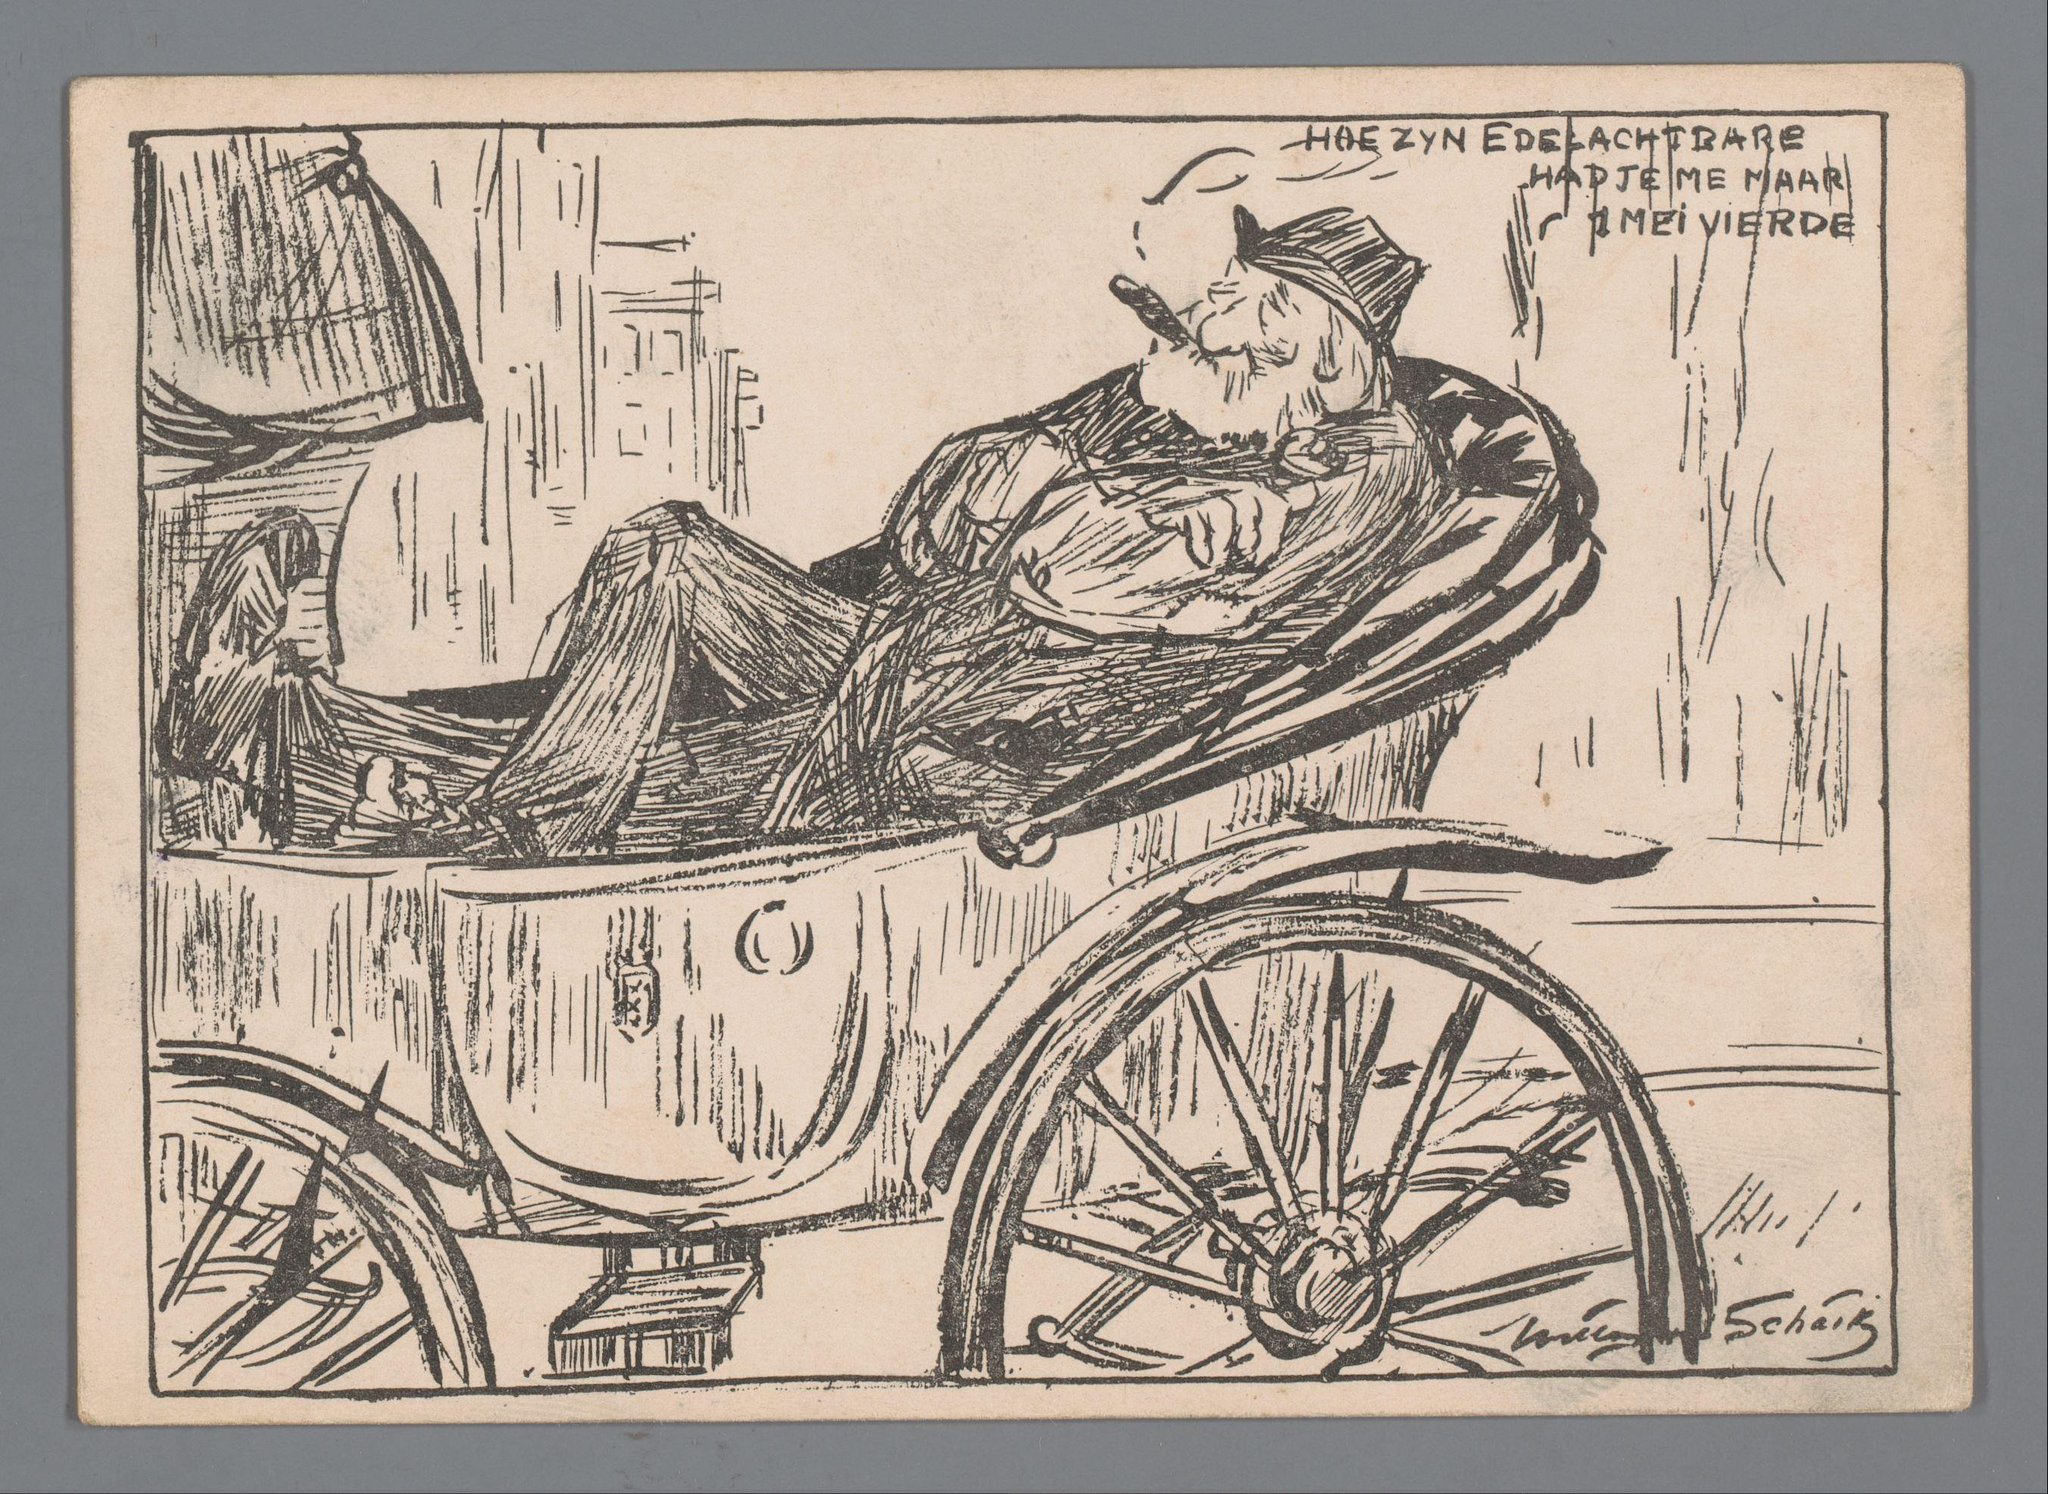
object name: postcard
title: Tweede Kamer droom van "Had je me maar"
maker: willem van schaik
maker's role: painter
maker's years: 1876-1938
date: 1921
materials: paper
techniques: printing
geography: amsterdam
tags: amsterdam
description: Briefkaart, tekeningen van een oude man met hoed en jas, in een auto stappend. Gesigneerd; o.: Willem van Schaik. Opschrift: zie titel.